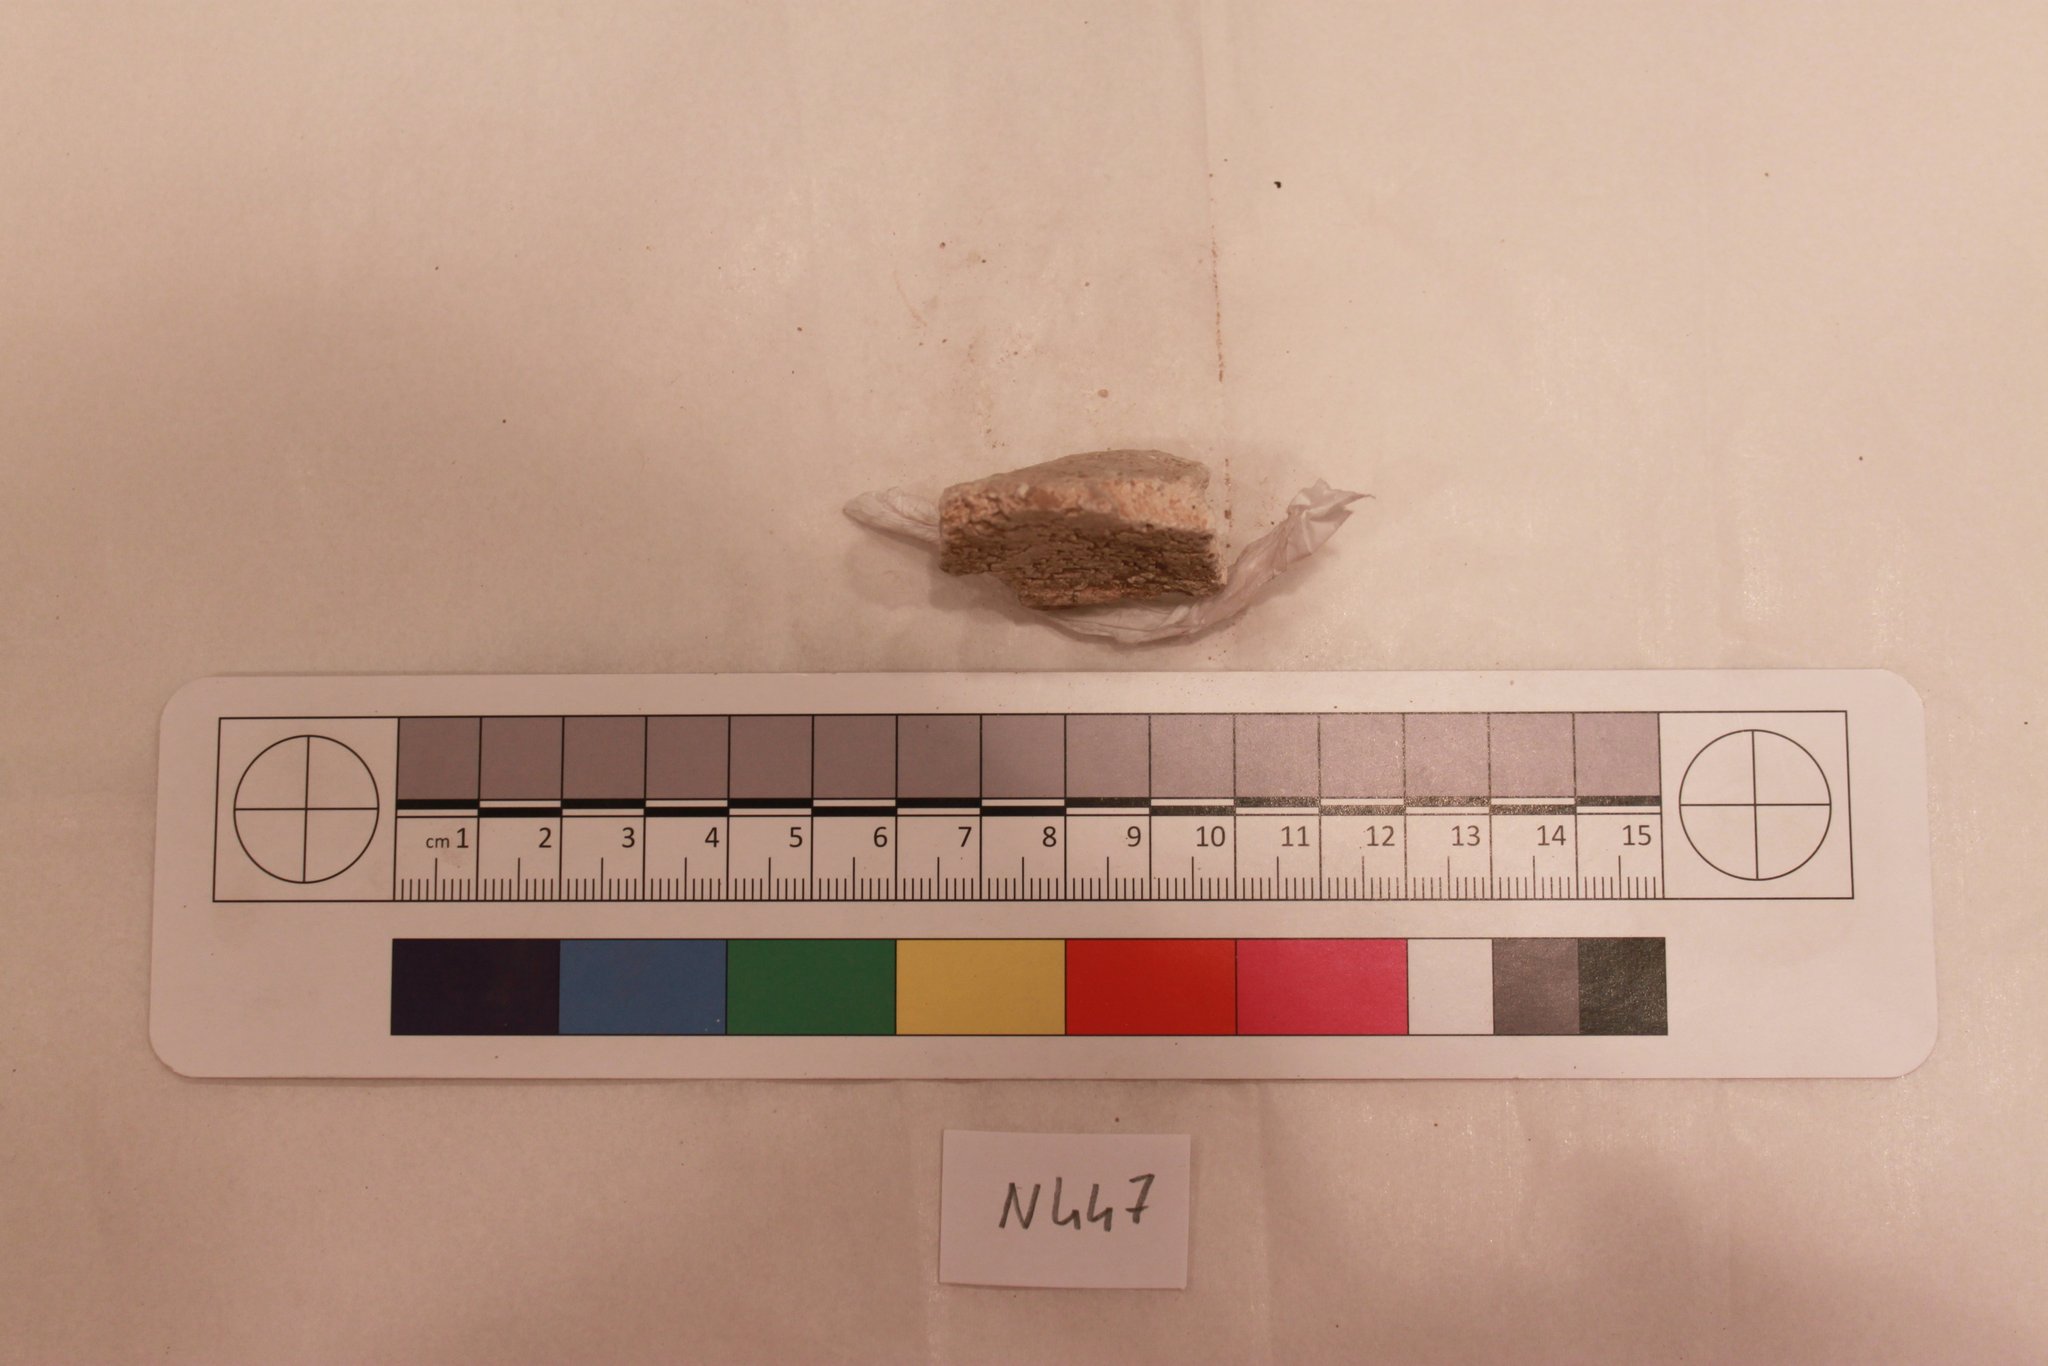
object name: fragment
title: Stucco Fragment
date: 701-1200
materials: plaster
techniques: carving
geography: iran